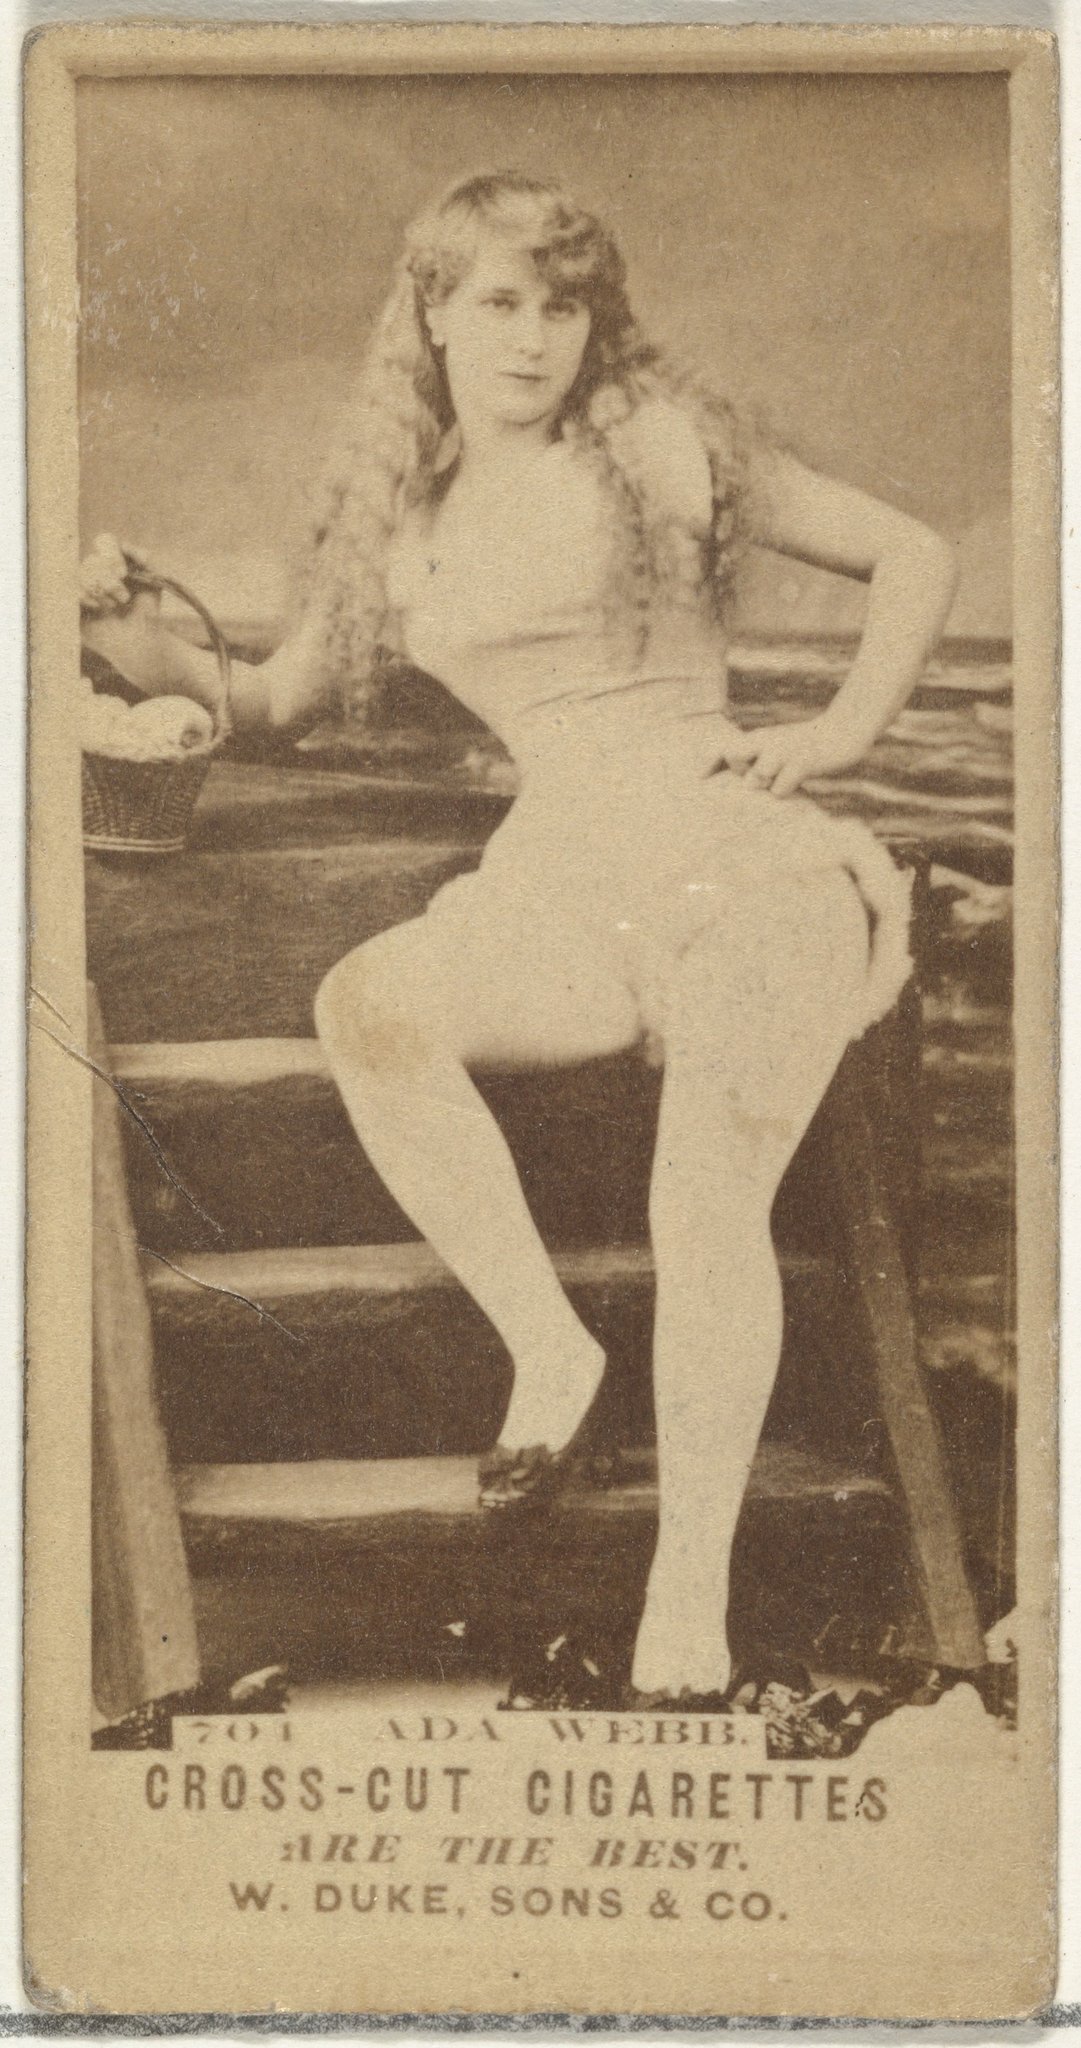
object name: photograph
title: Card Number 701, Miss Ada Webb, from the Actors and Actresses series (N145-3) issued by Duke Sons & Co. to promote Cross Cut Cigarettes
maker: w. duke, sons & co.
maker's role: publisher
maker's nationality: american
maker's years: 1870-1920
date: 1880-1889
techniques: albumen silver print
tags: portraits,women,actresses